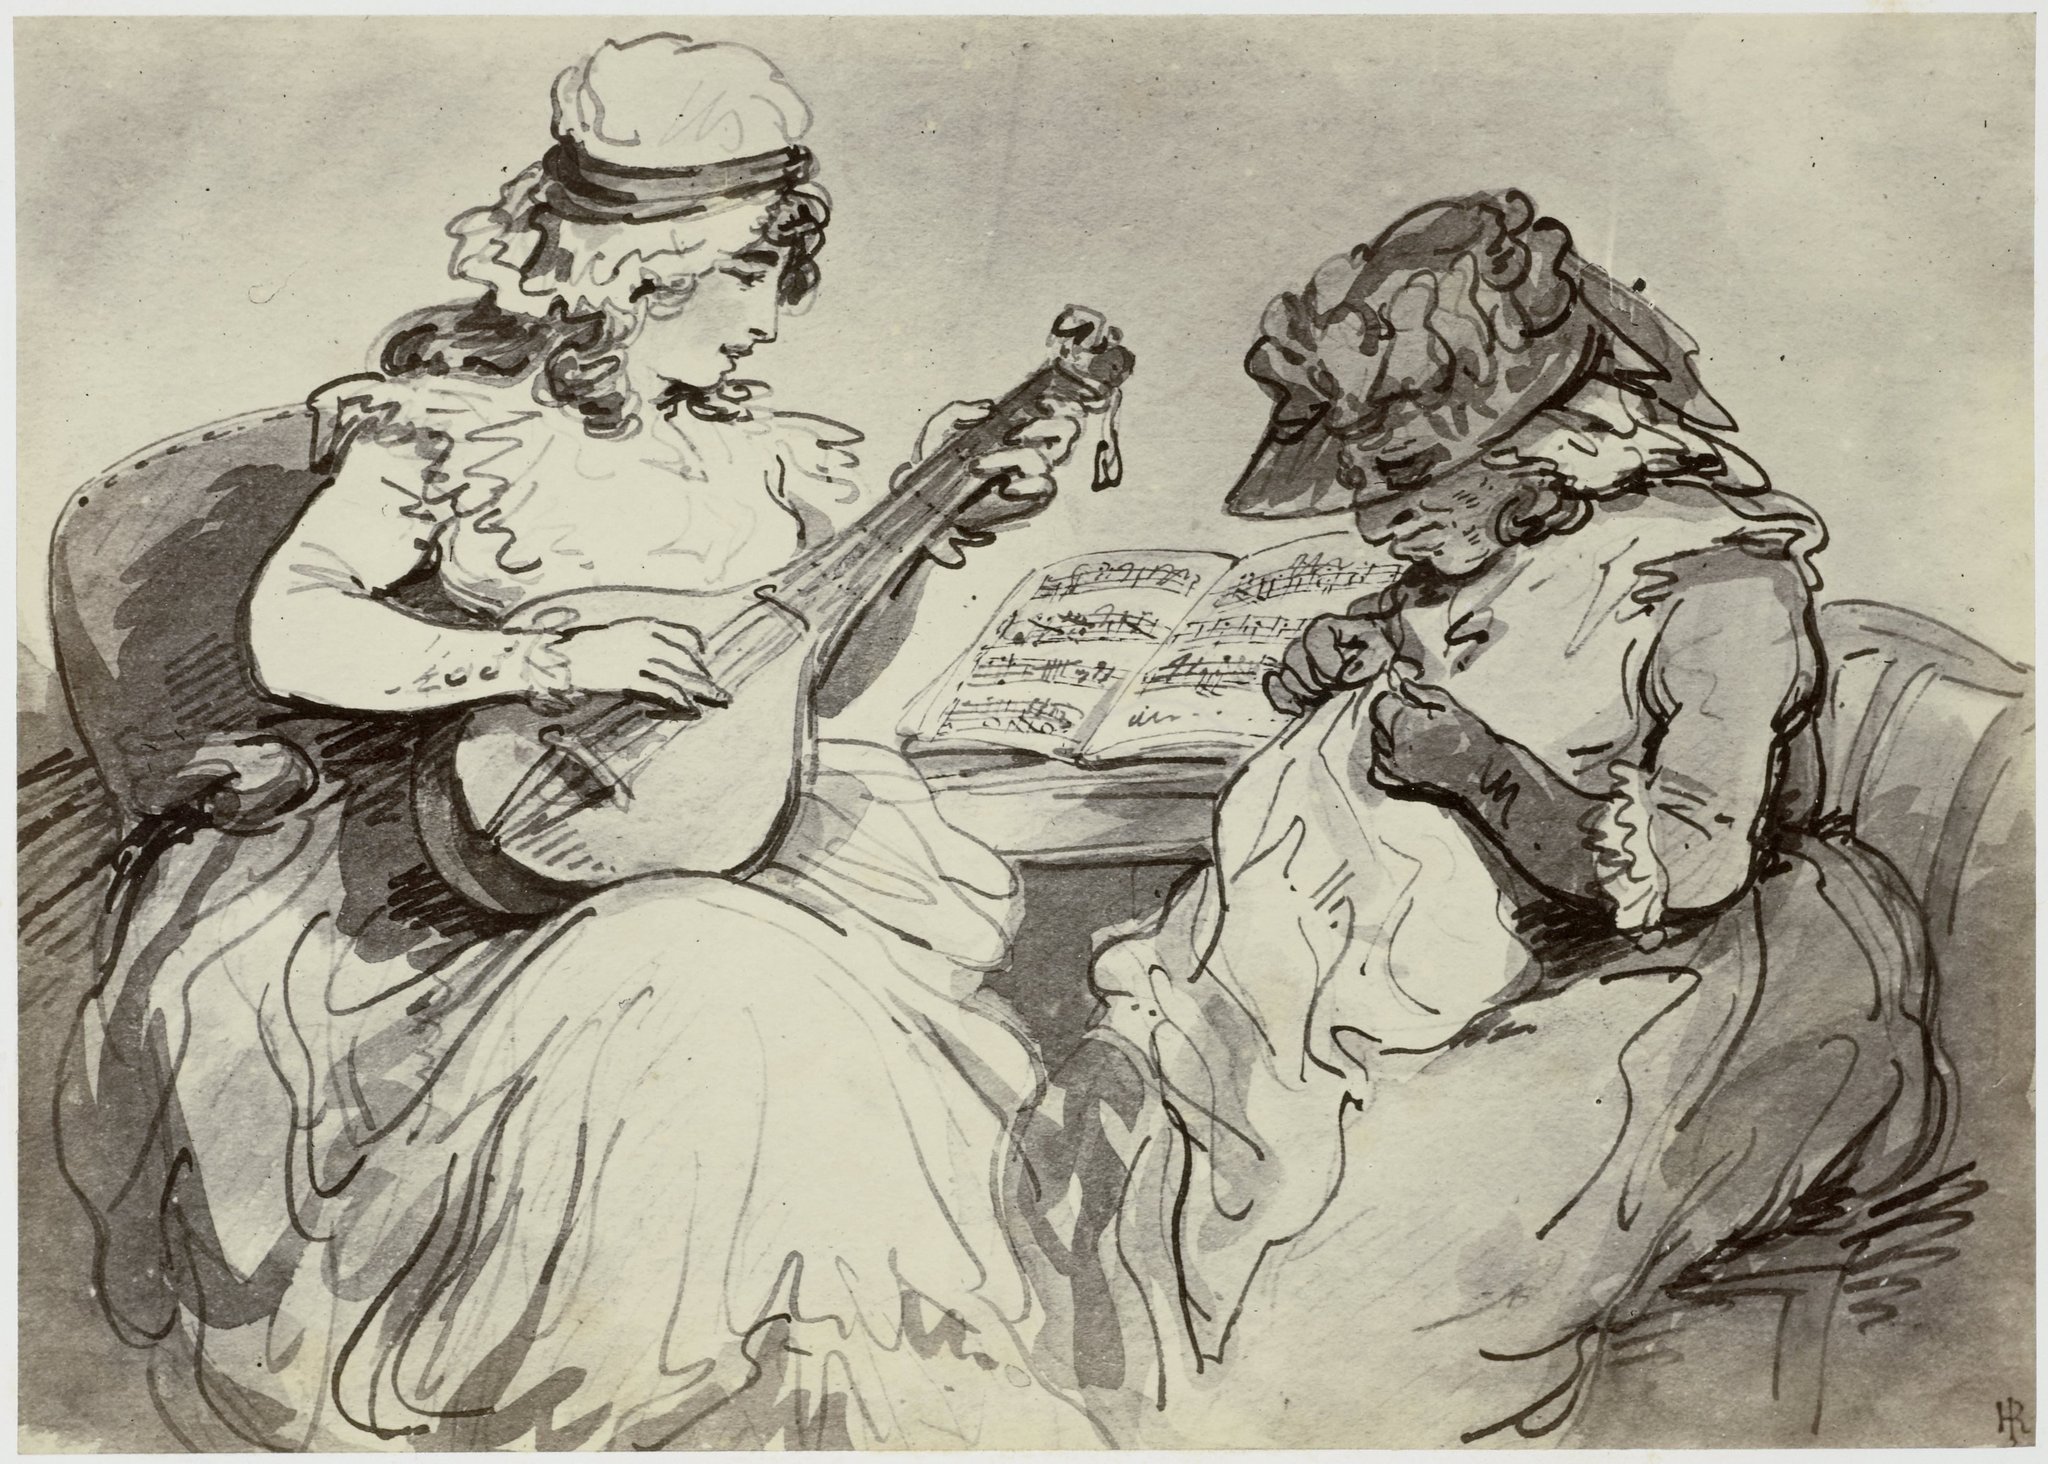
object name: photograph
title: Thomas Rowlandson, A Visit to my Grandmother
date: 1855-1858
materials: cardboard, paper, photographic support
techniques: albumen print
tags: london, print maker, thomas rowlandson, drawing, sketch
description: Fotoreproductie van tekening in 'The Reveley Collection of Drawings at Brynygwin', afb. 57.